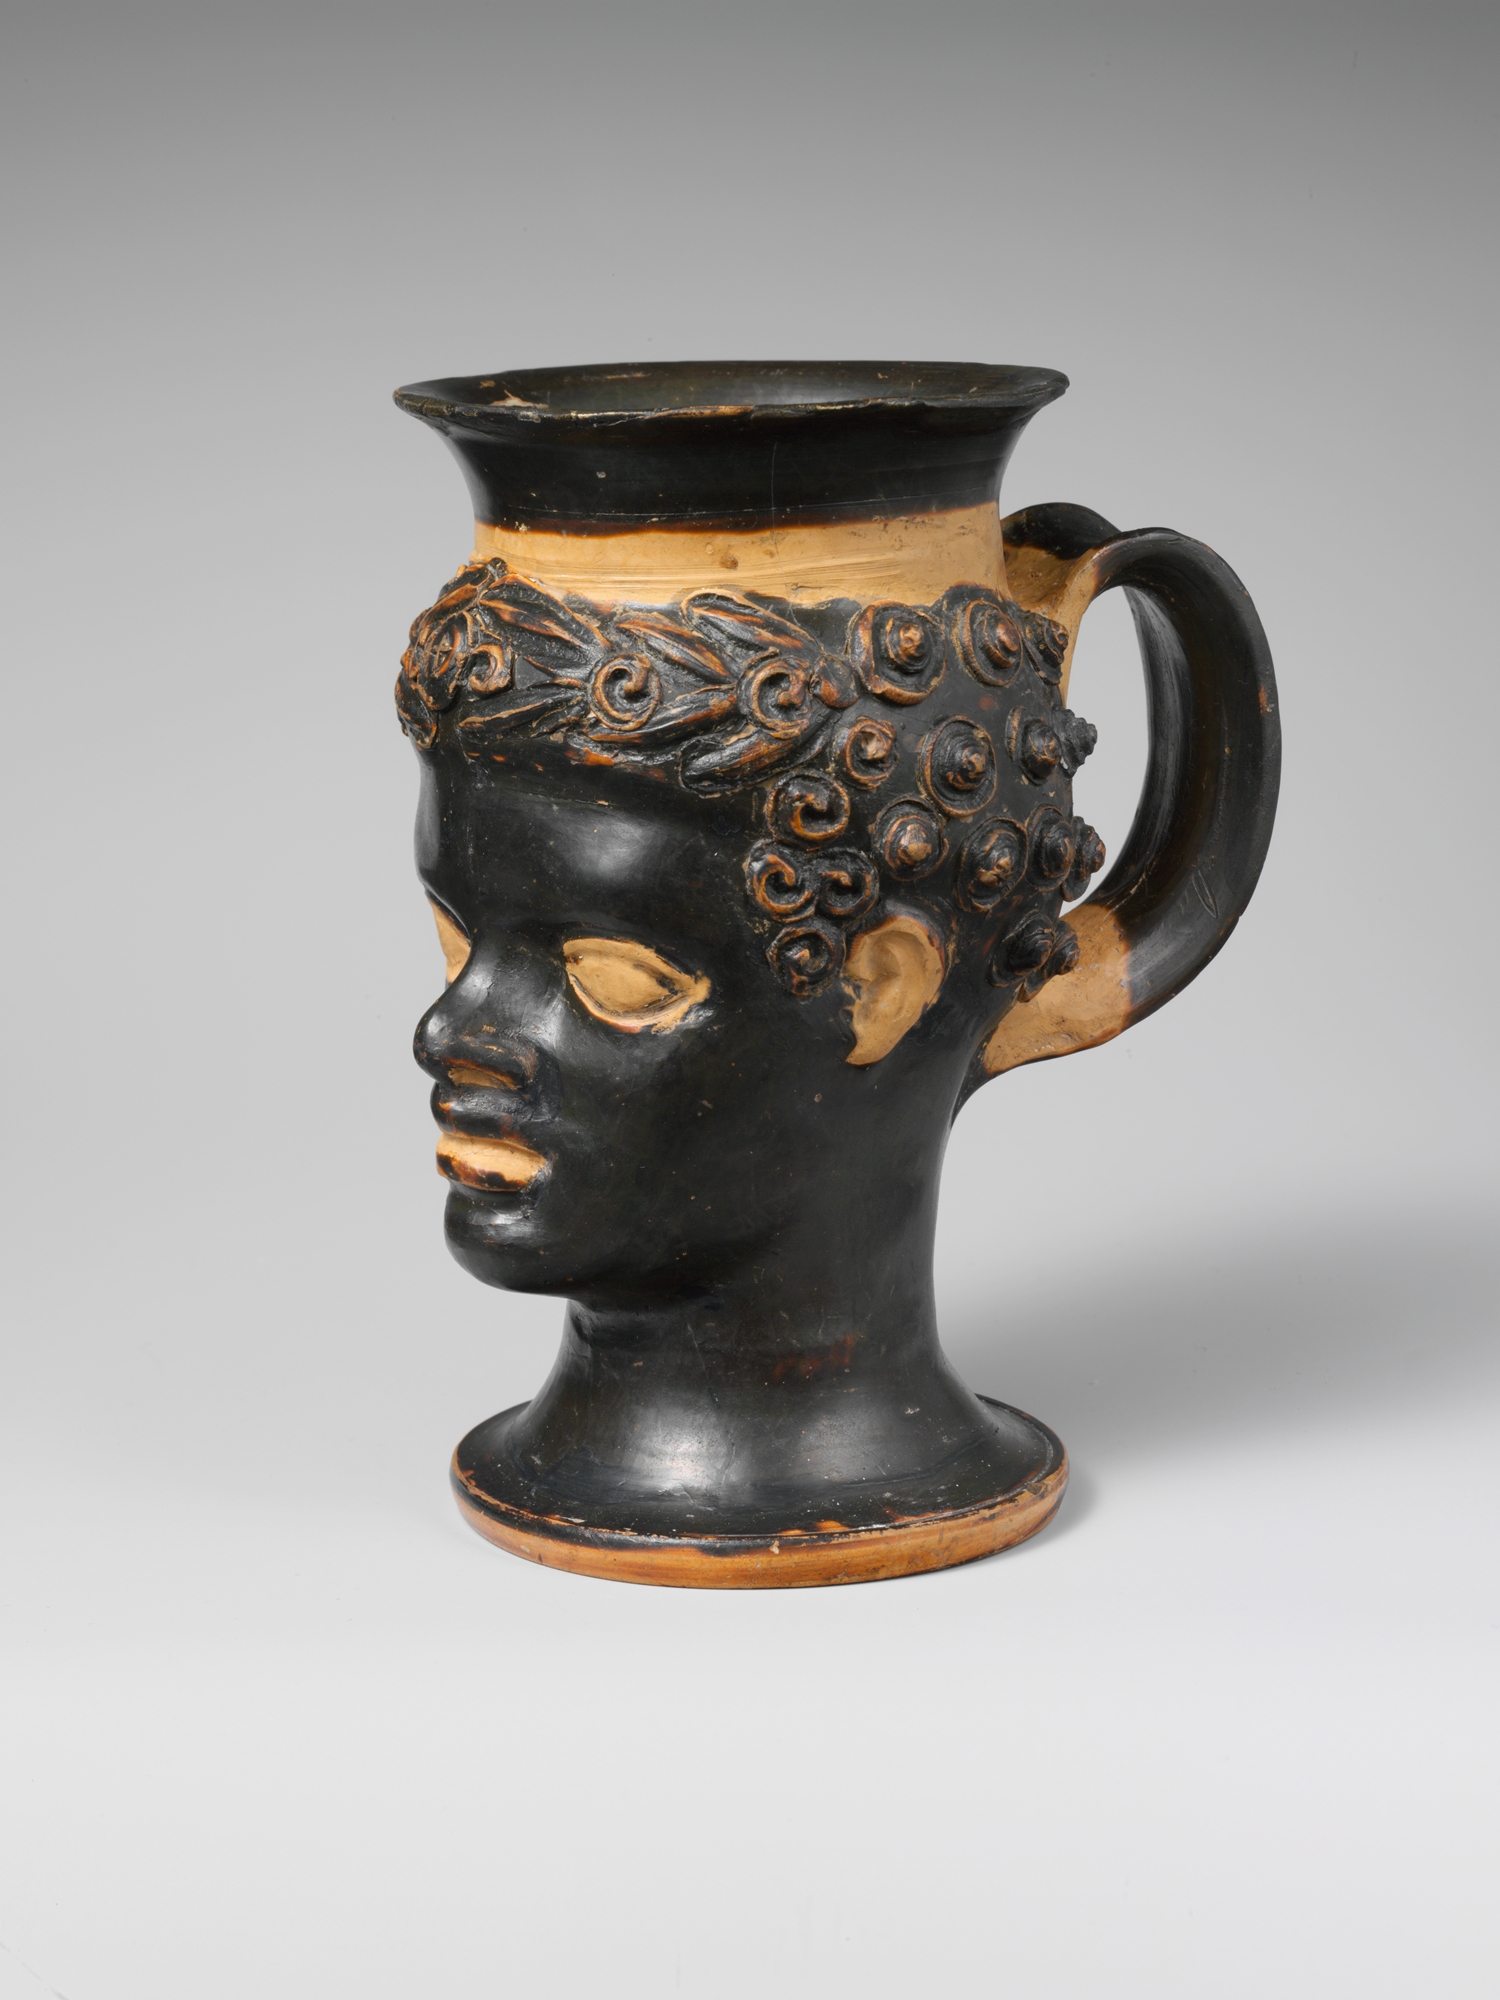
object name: mug in the form of a head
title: Terracotta mug in the form of a Black African youth's head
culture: etruscan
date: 334-301 BCE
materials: terracotta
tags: heads,boys